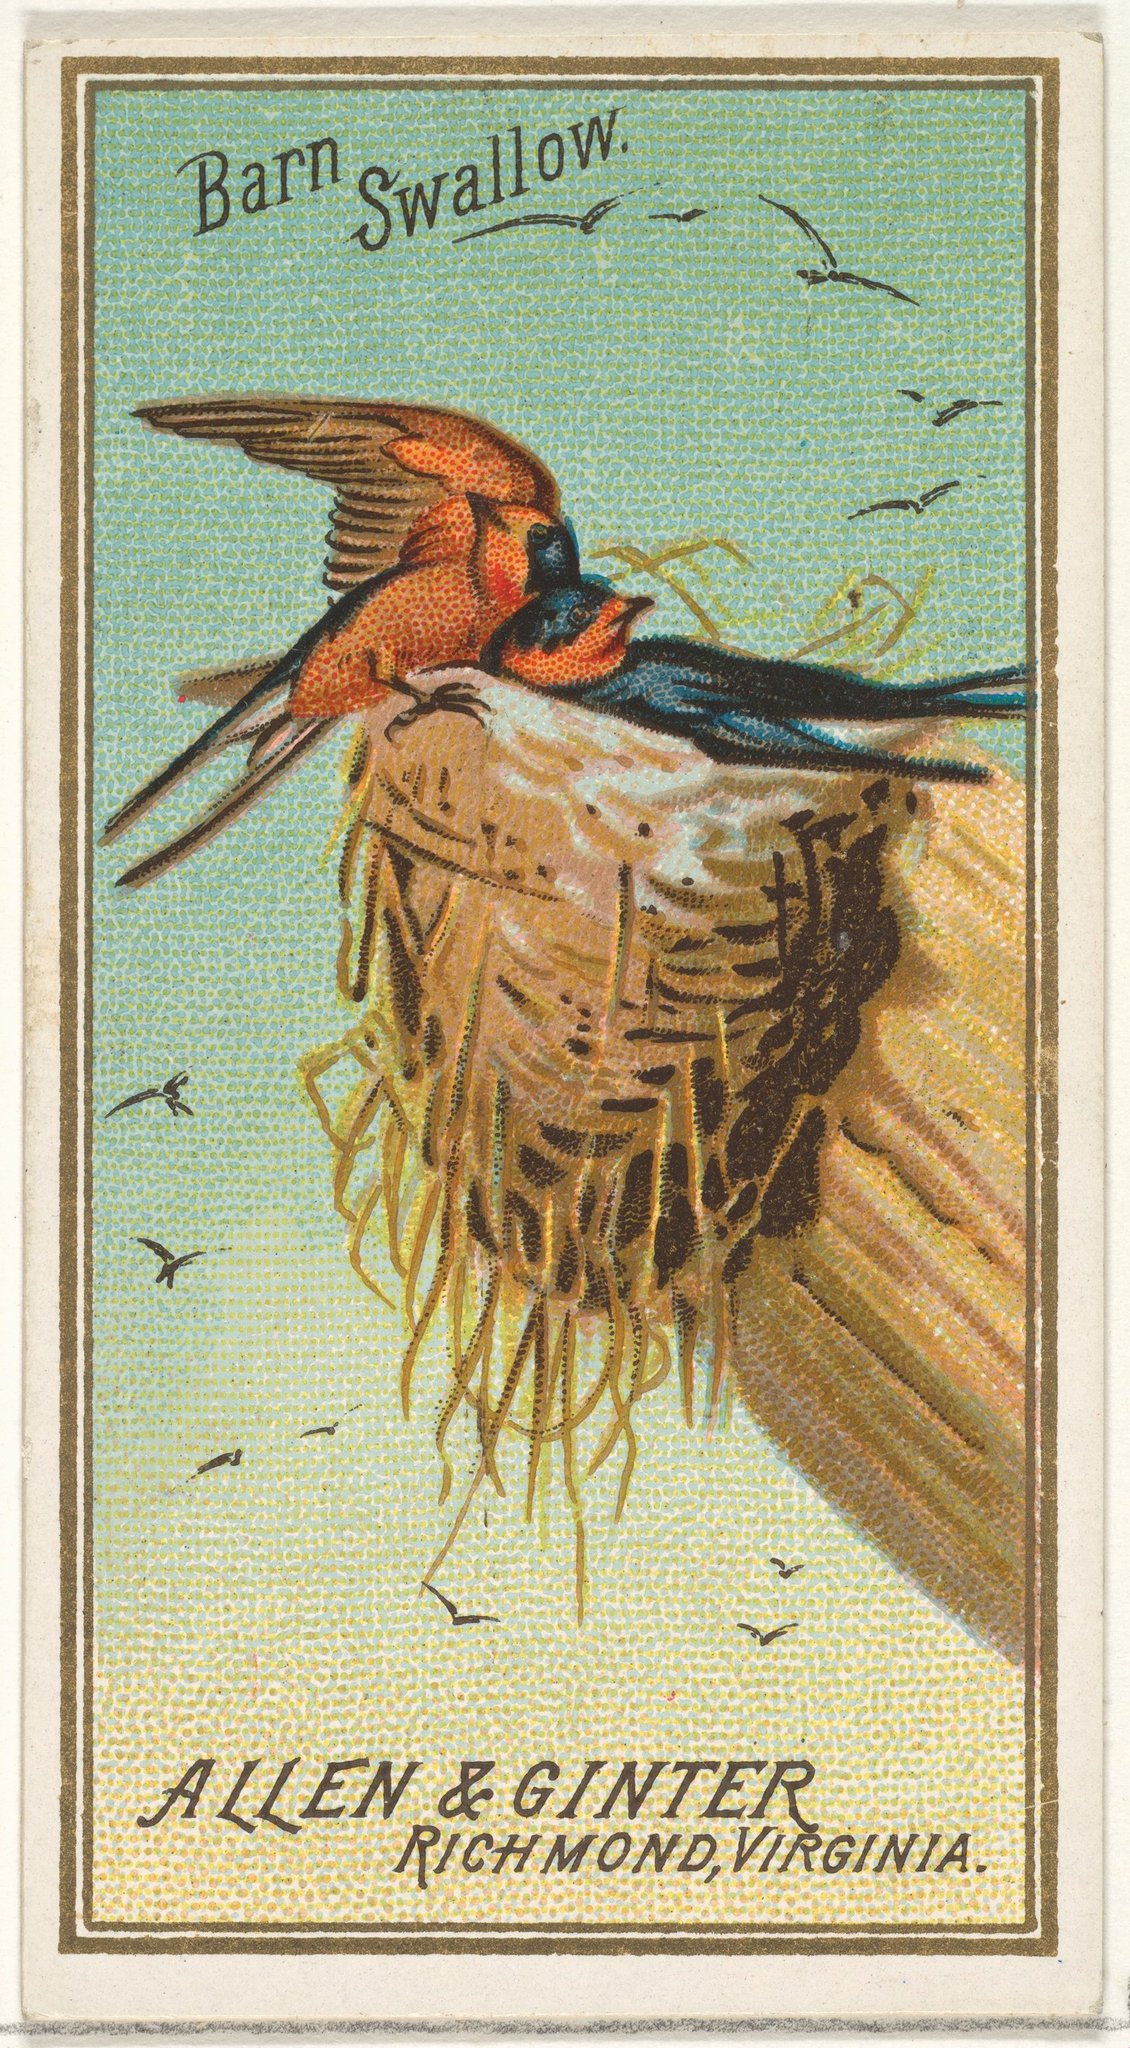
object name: print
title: Barn Swallow, from the Birds of America series (N4) for Allen & Ginter Cigarettes Brands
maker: allen & ginter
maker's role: publisher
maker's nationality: american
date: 1888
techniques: color lithograph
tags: birds